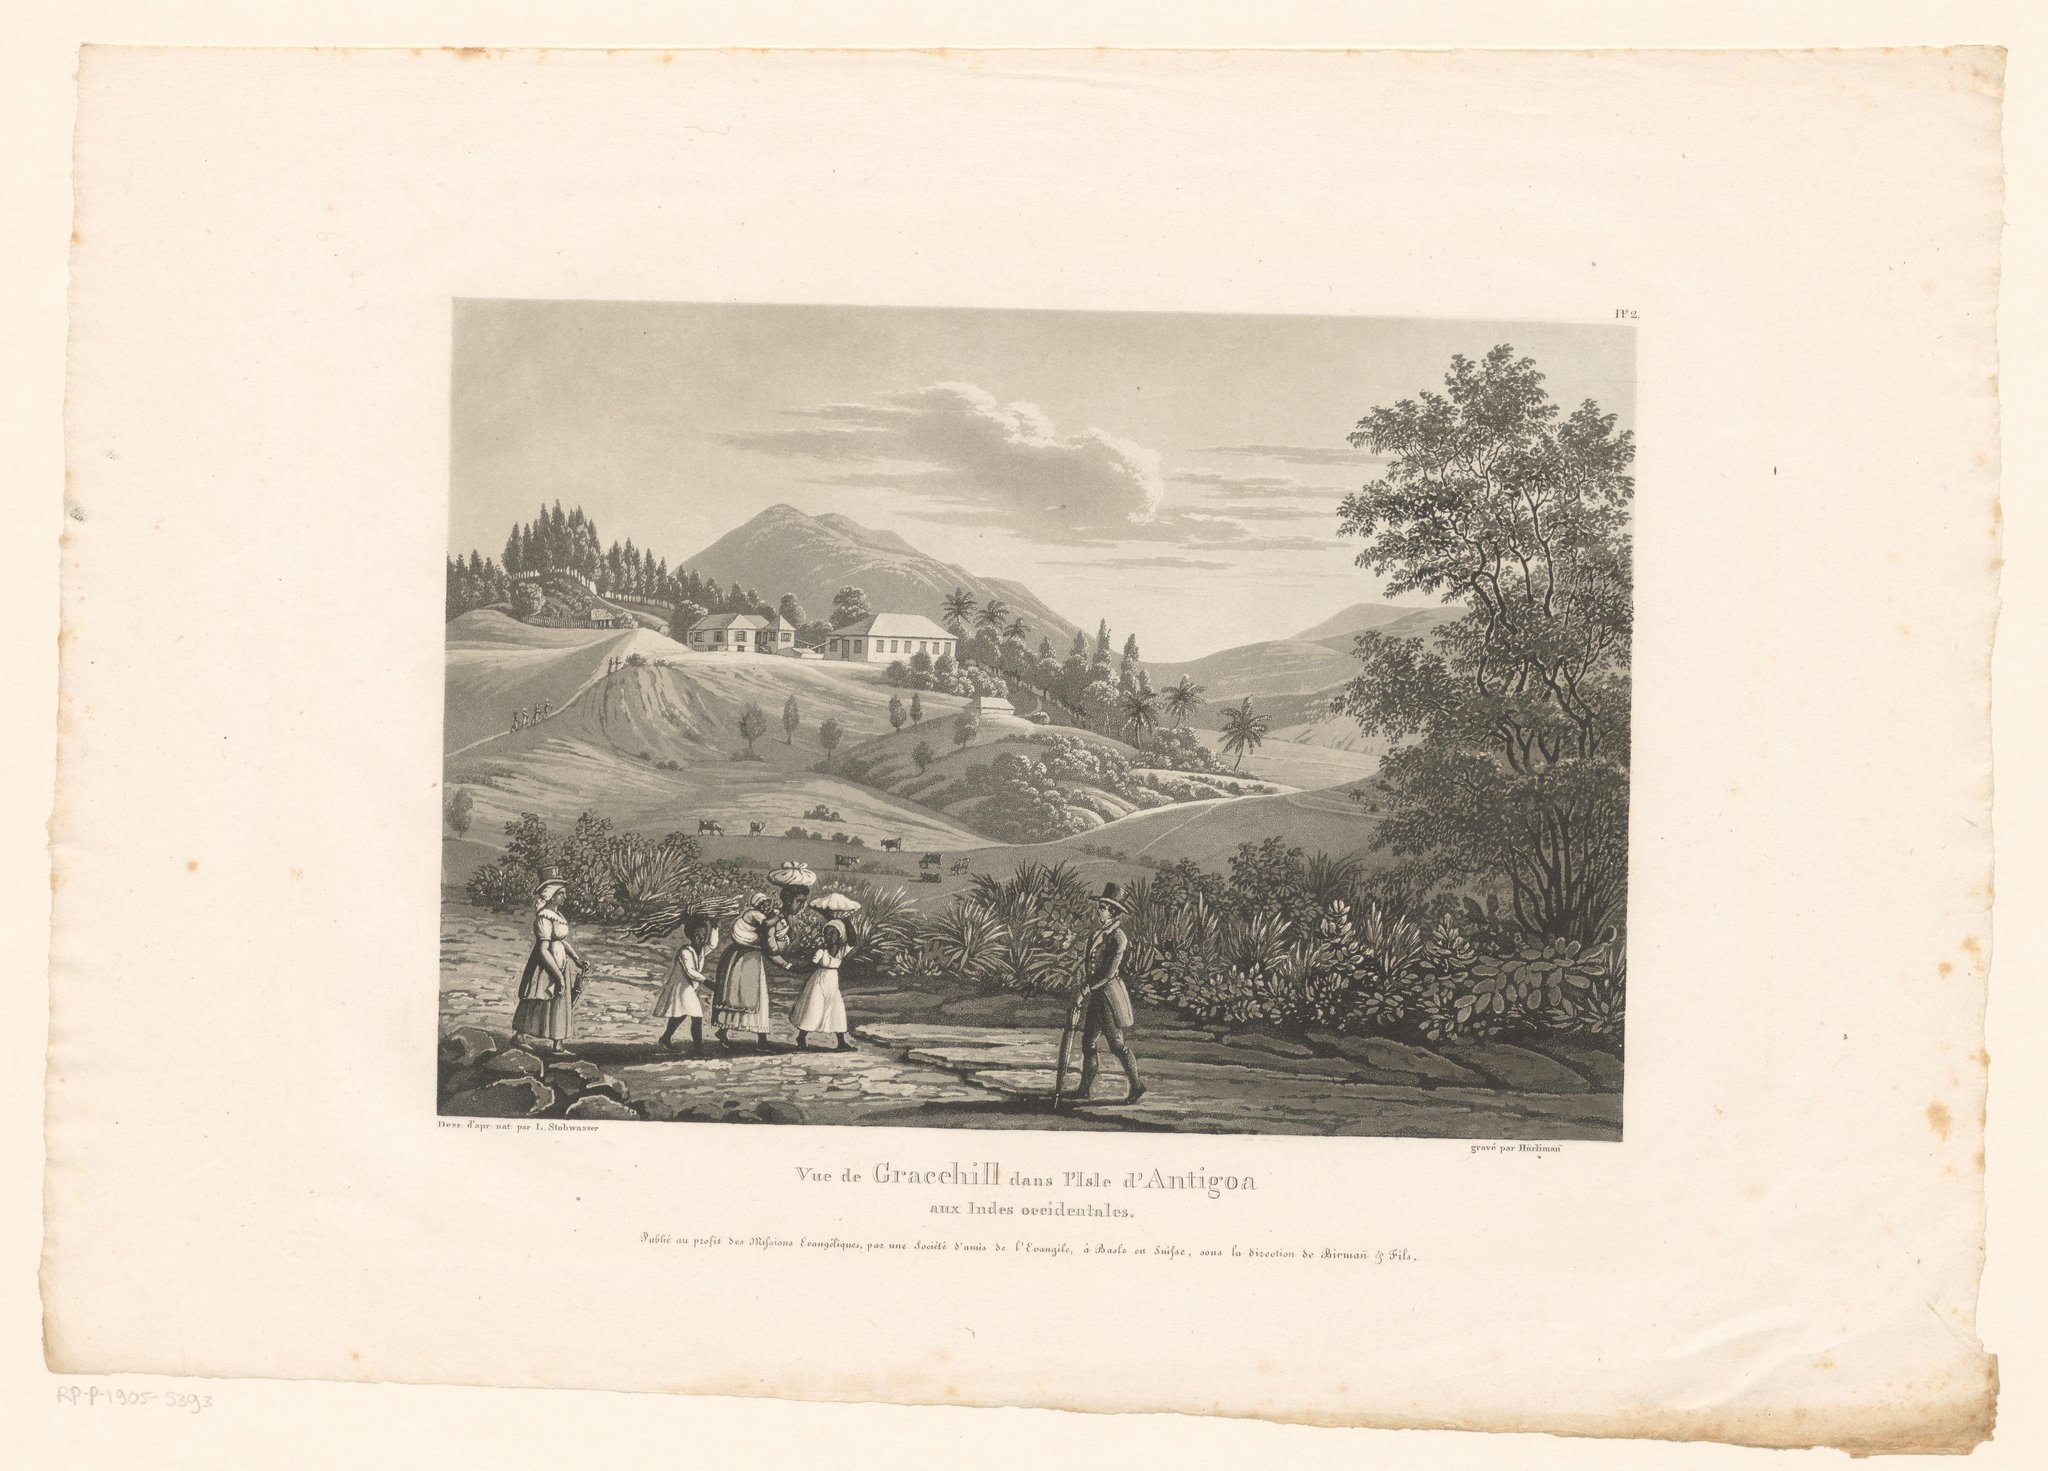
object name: print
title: Gezicht op de heuvels van het eiland Antigua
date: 1803-1850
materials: paper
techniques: aquatint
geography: basel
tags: low hill country, cow, umbrella, agriculture, carrying something on the head or on the shoulders, mountains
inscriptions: number: ‘2’, collector's mark: Lugt 2228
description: Gepubliceerd door de Zwisterse uitgever Birmann & Fils ten behoeve van de evangelische missies.